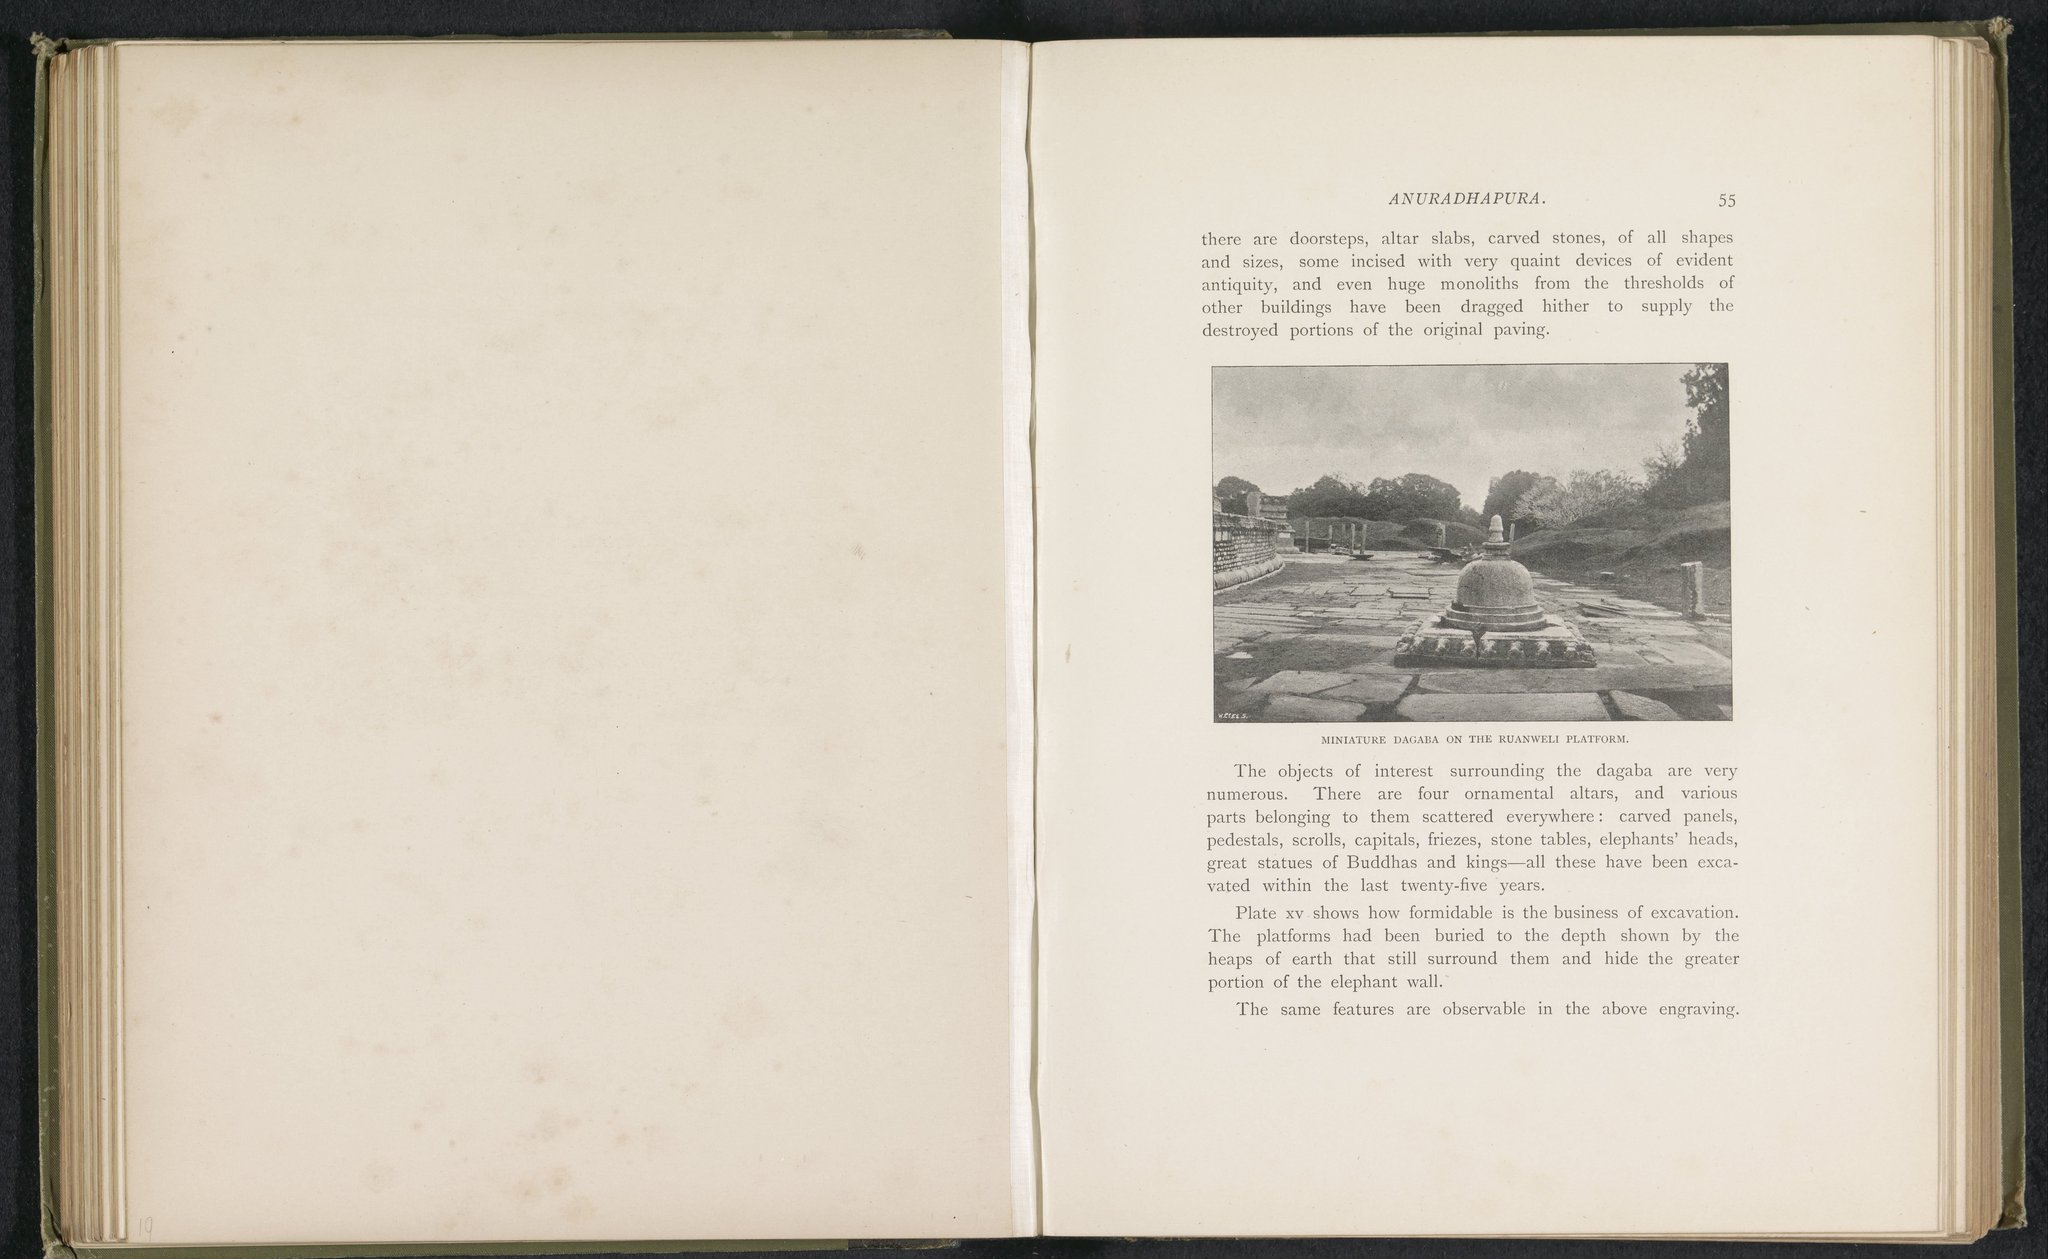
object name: photomechanical print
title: Miniature stupa in the Ruwanwelisaya stupa complex at Anuradhapura, Sri Lanka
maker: henry william cave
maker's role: fotograaf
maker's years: 1854-1913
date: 1896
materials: paper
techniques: autotype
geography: anuradhapura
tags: places and objects of worship ~ hinduism, buddhism, jainism, sculpture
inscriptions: title: ‘MINIATURE DAGABA ON THE RUANWELI PLATFORM.’, signature: ‘W. P [?]’